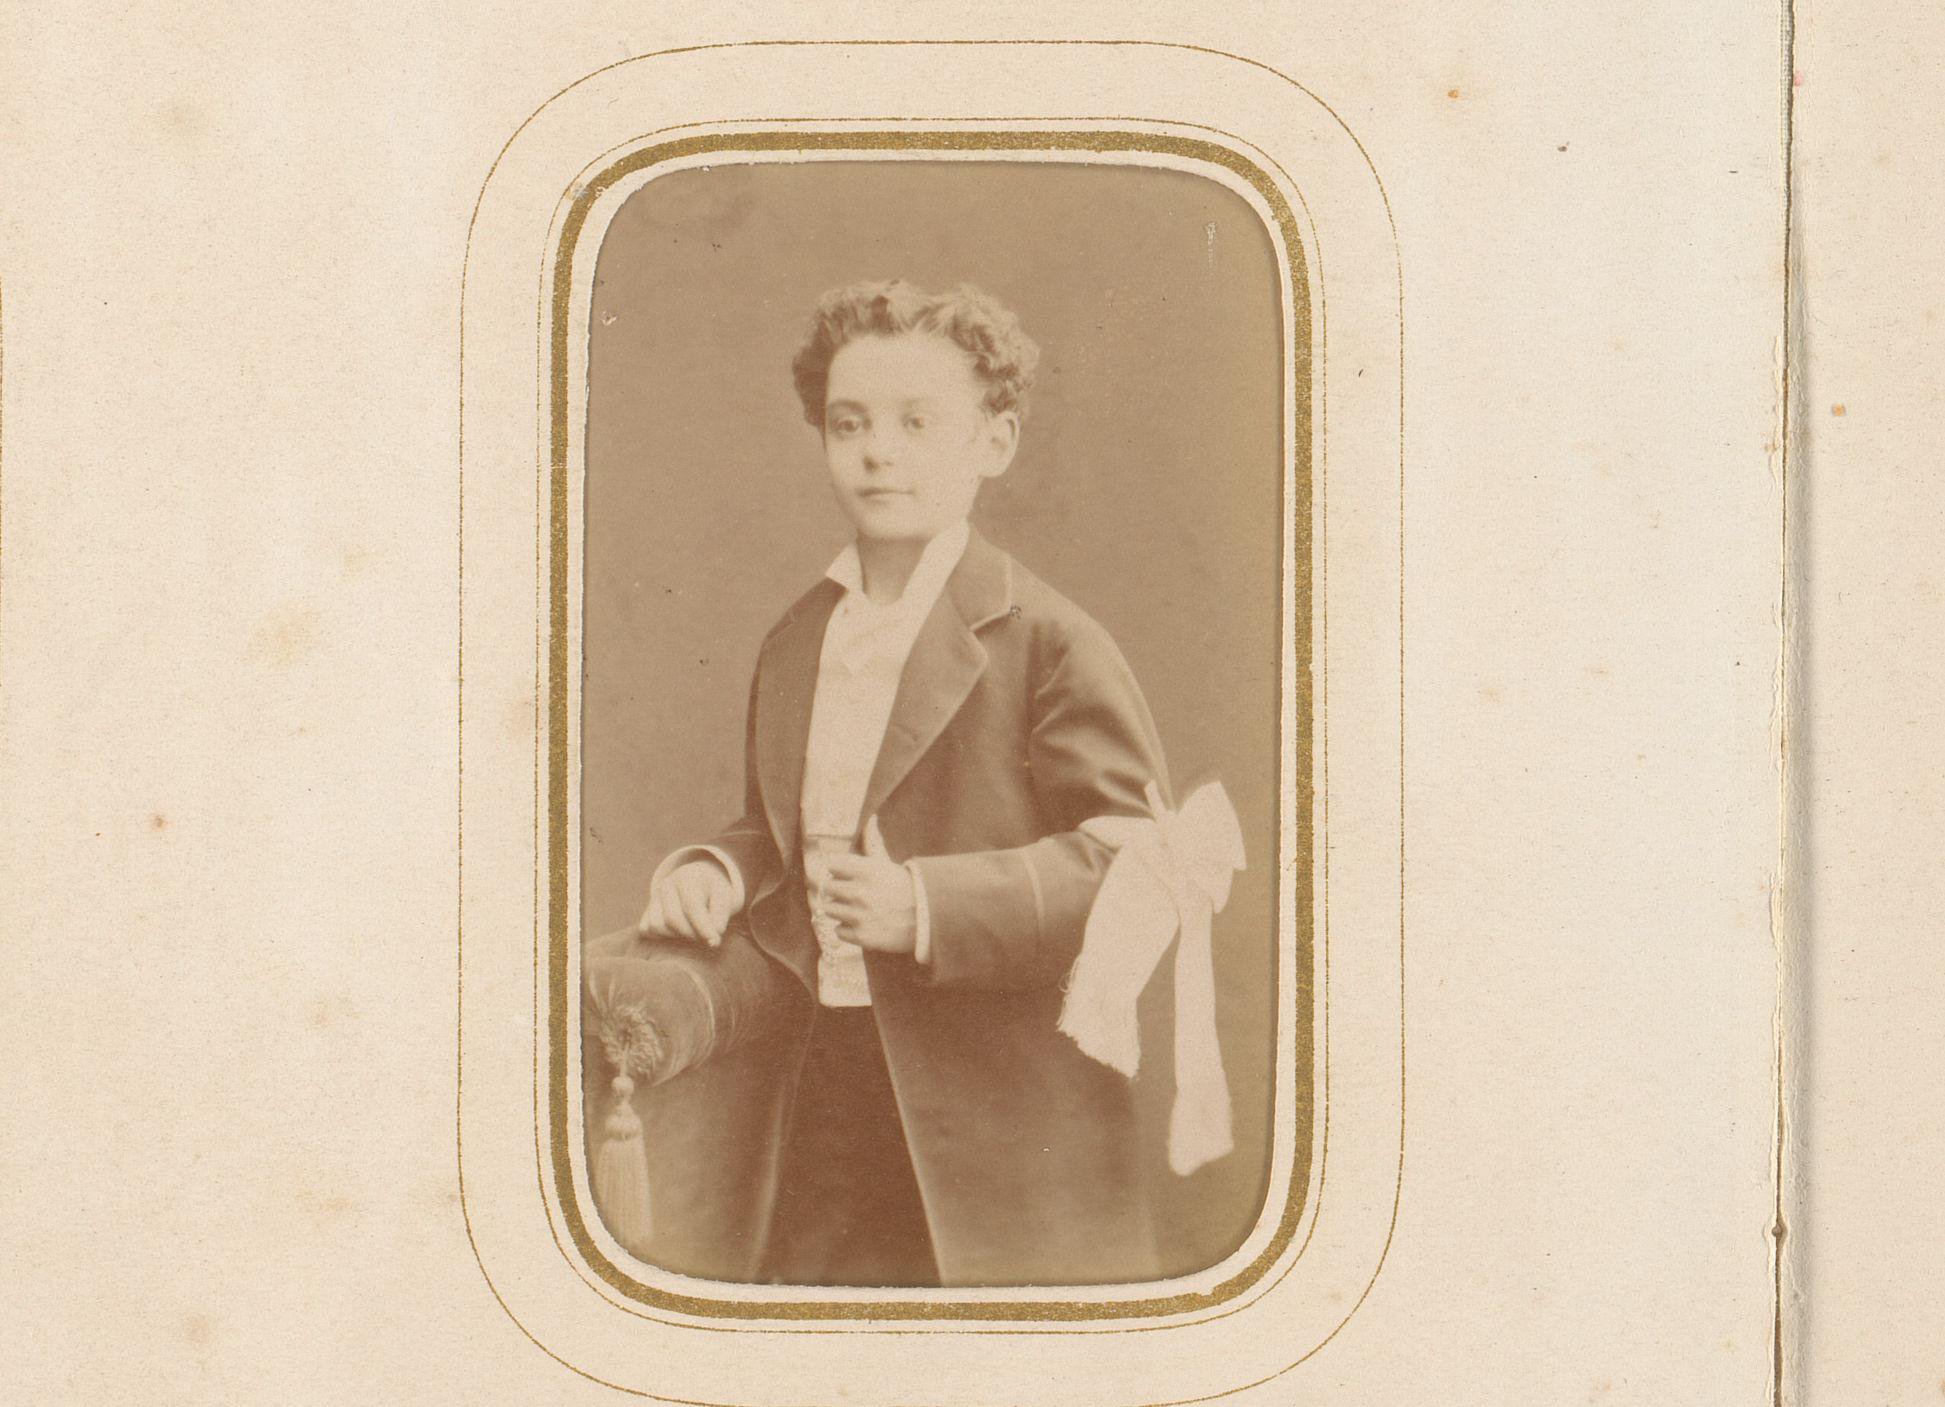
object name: carte de visite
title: Portret van een jongen met strik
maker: marius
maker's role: fotograaf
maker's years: 1832-1908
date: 1860-1890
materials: cardboard, photographic support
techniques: albumen print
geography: paris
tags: boy (child between toddler and youth)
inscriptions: inscription: ‘Marius/ 55, Rue Réaumur, 55/ Entre le Boulevard Sébastopol/ et la Rue St. Denis/ Paris’